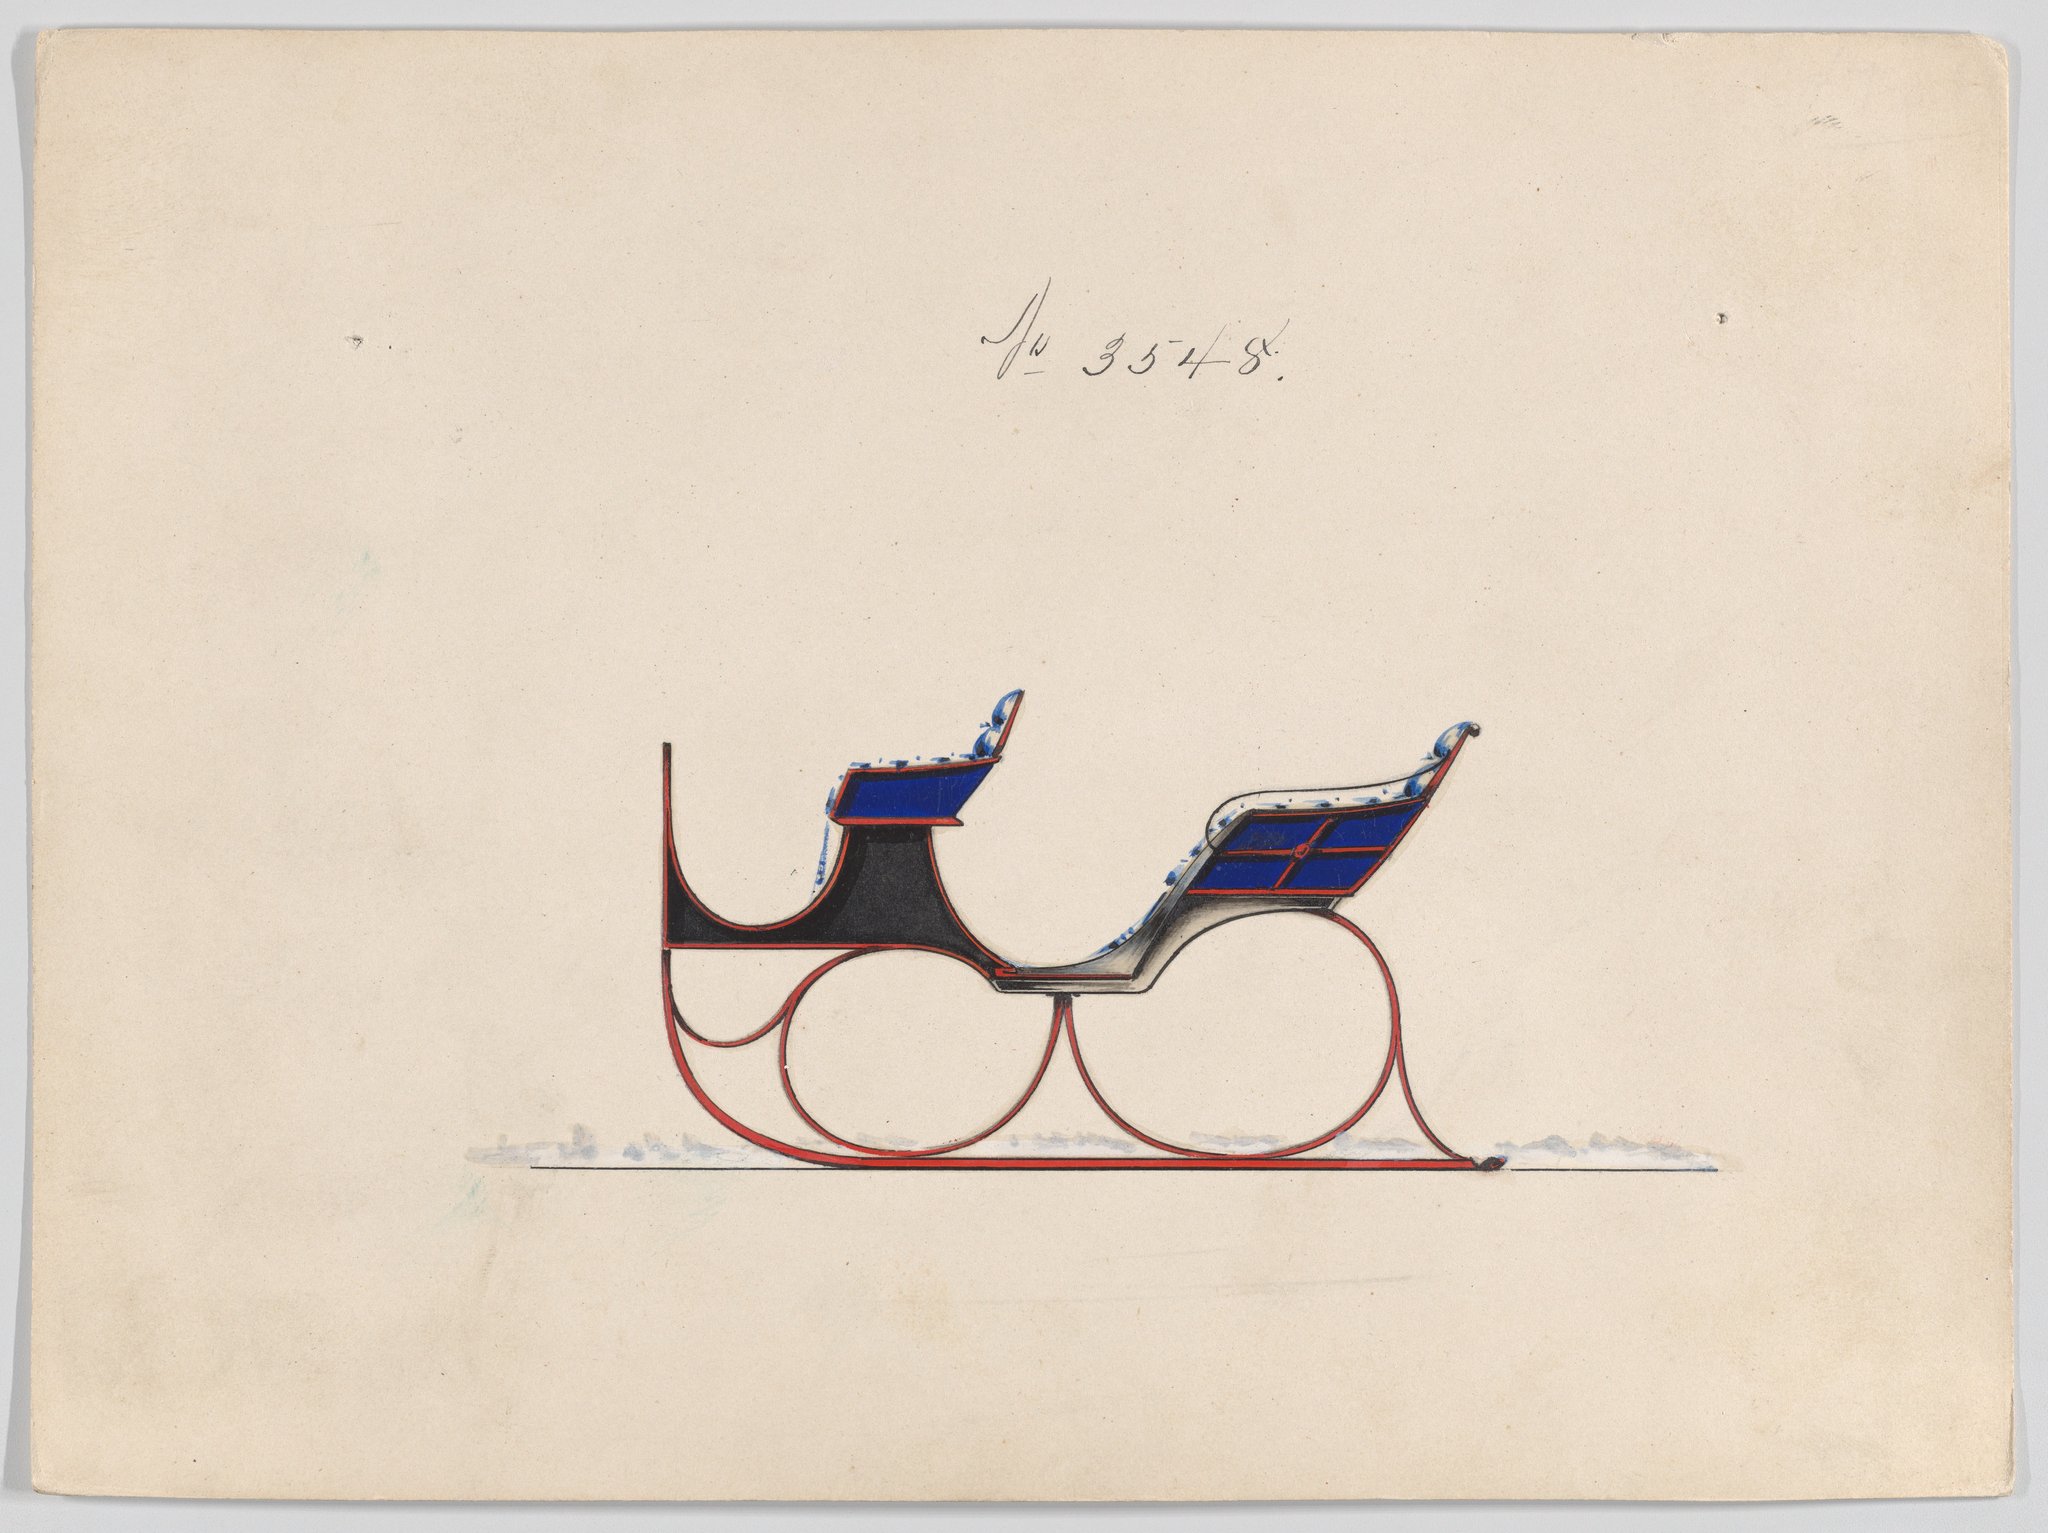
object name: drawing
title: Design for 2 Seat Victoria Sleigh, no. 3548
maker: brewster & co.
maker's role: manufacturer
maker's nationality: american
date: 1879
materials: gouache, gum arabic, ink, watercolor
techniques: pen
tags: sleighs